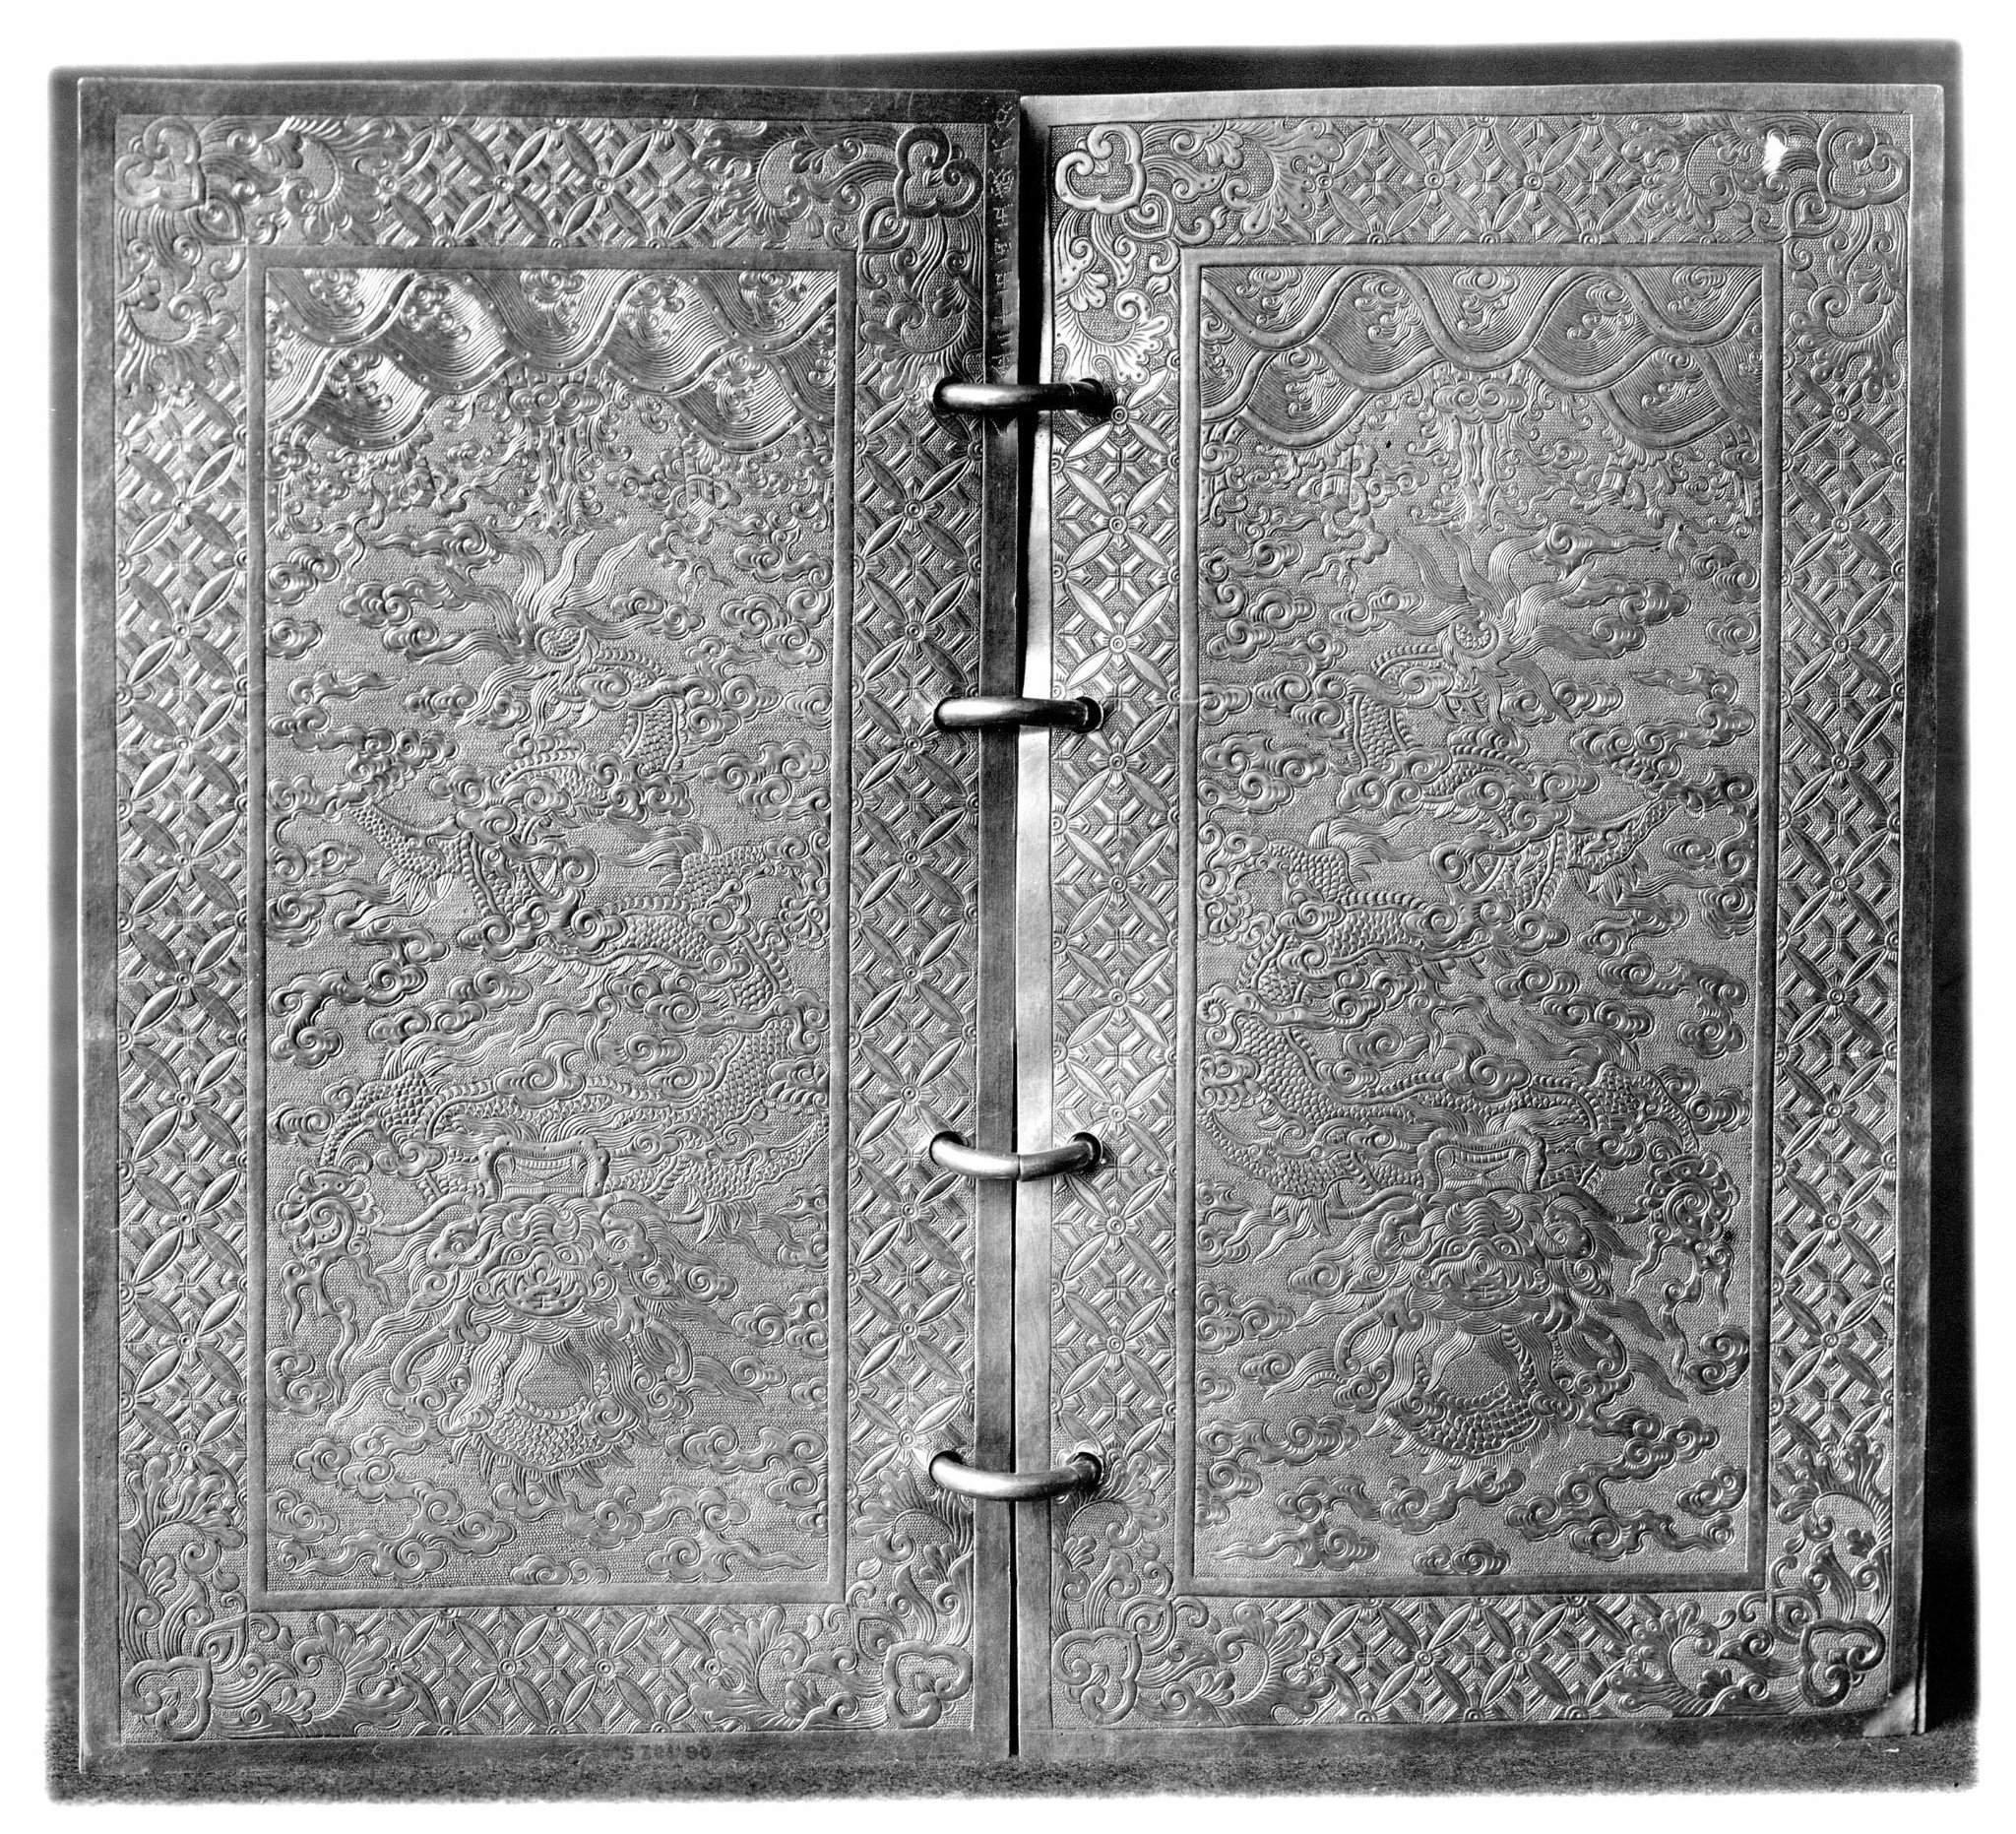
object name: imperial decree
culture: chinese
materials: gold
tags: dragons